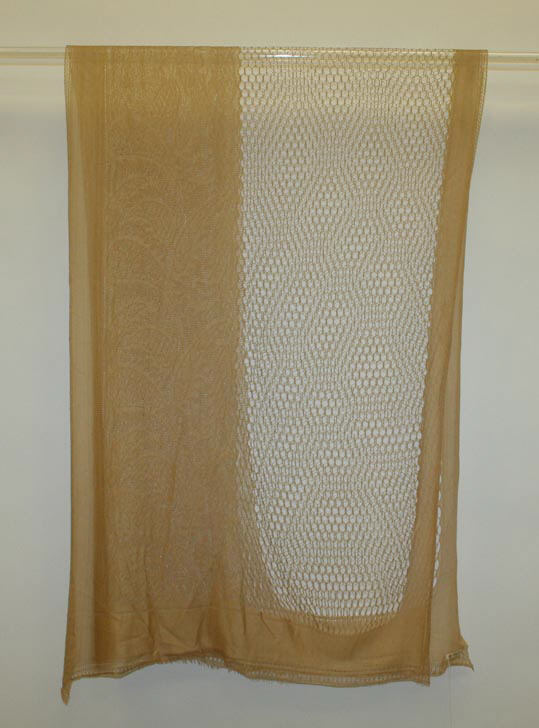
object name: scarf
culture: american or european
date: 1700-1945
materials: silk